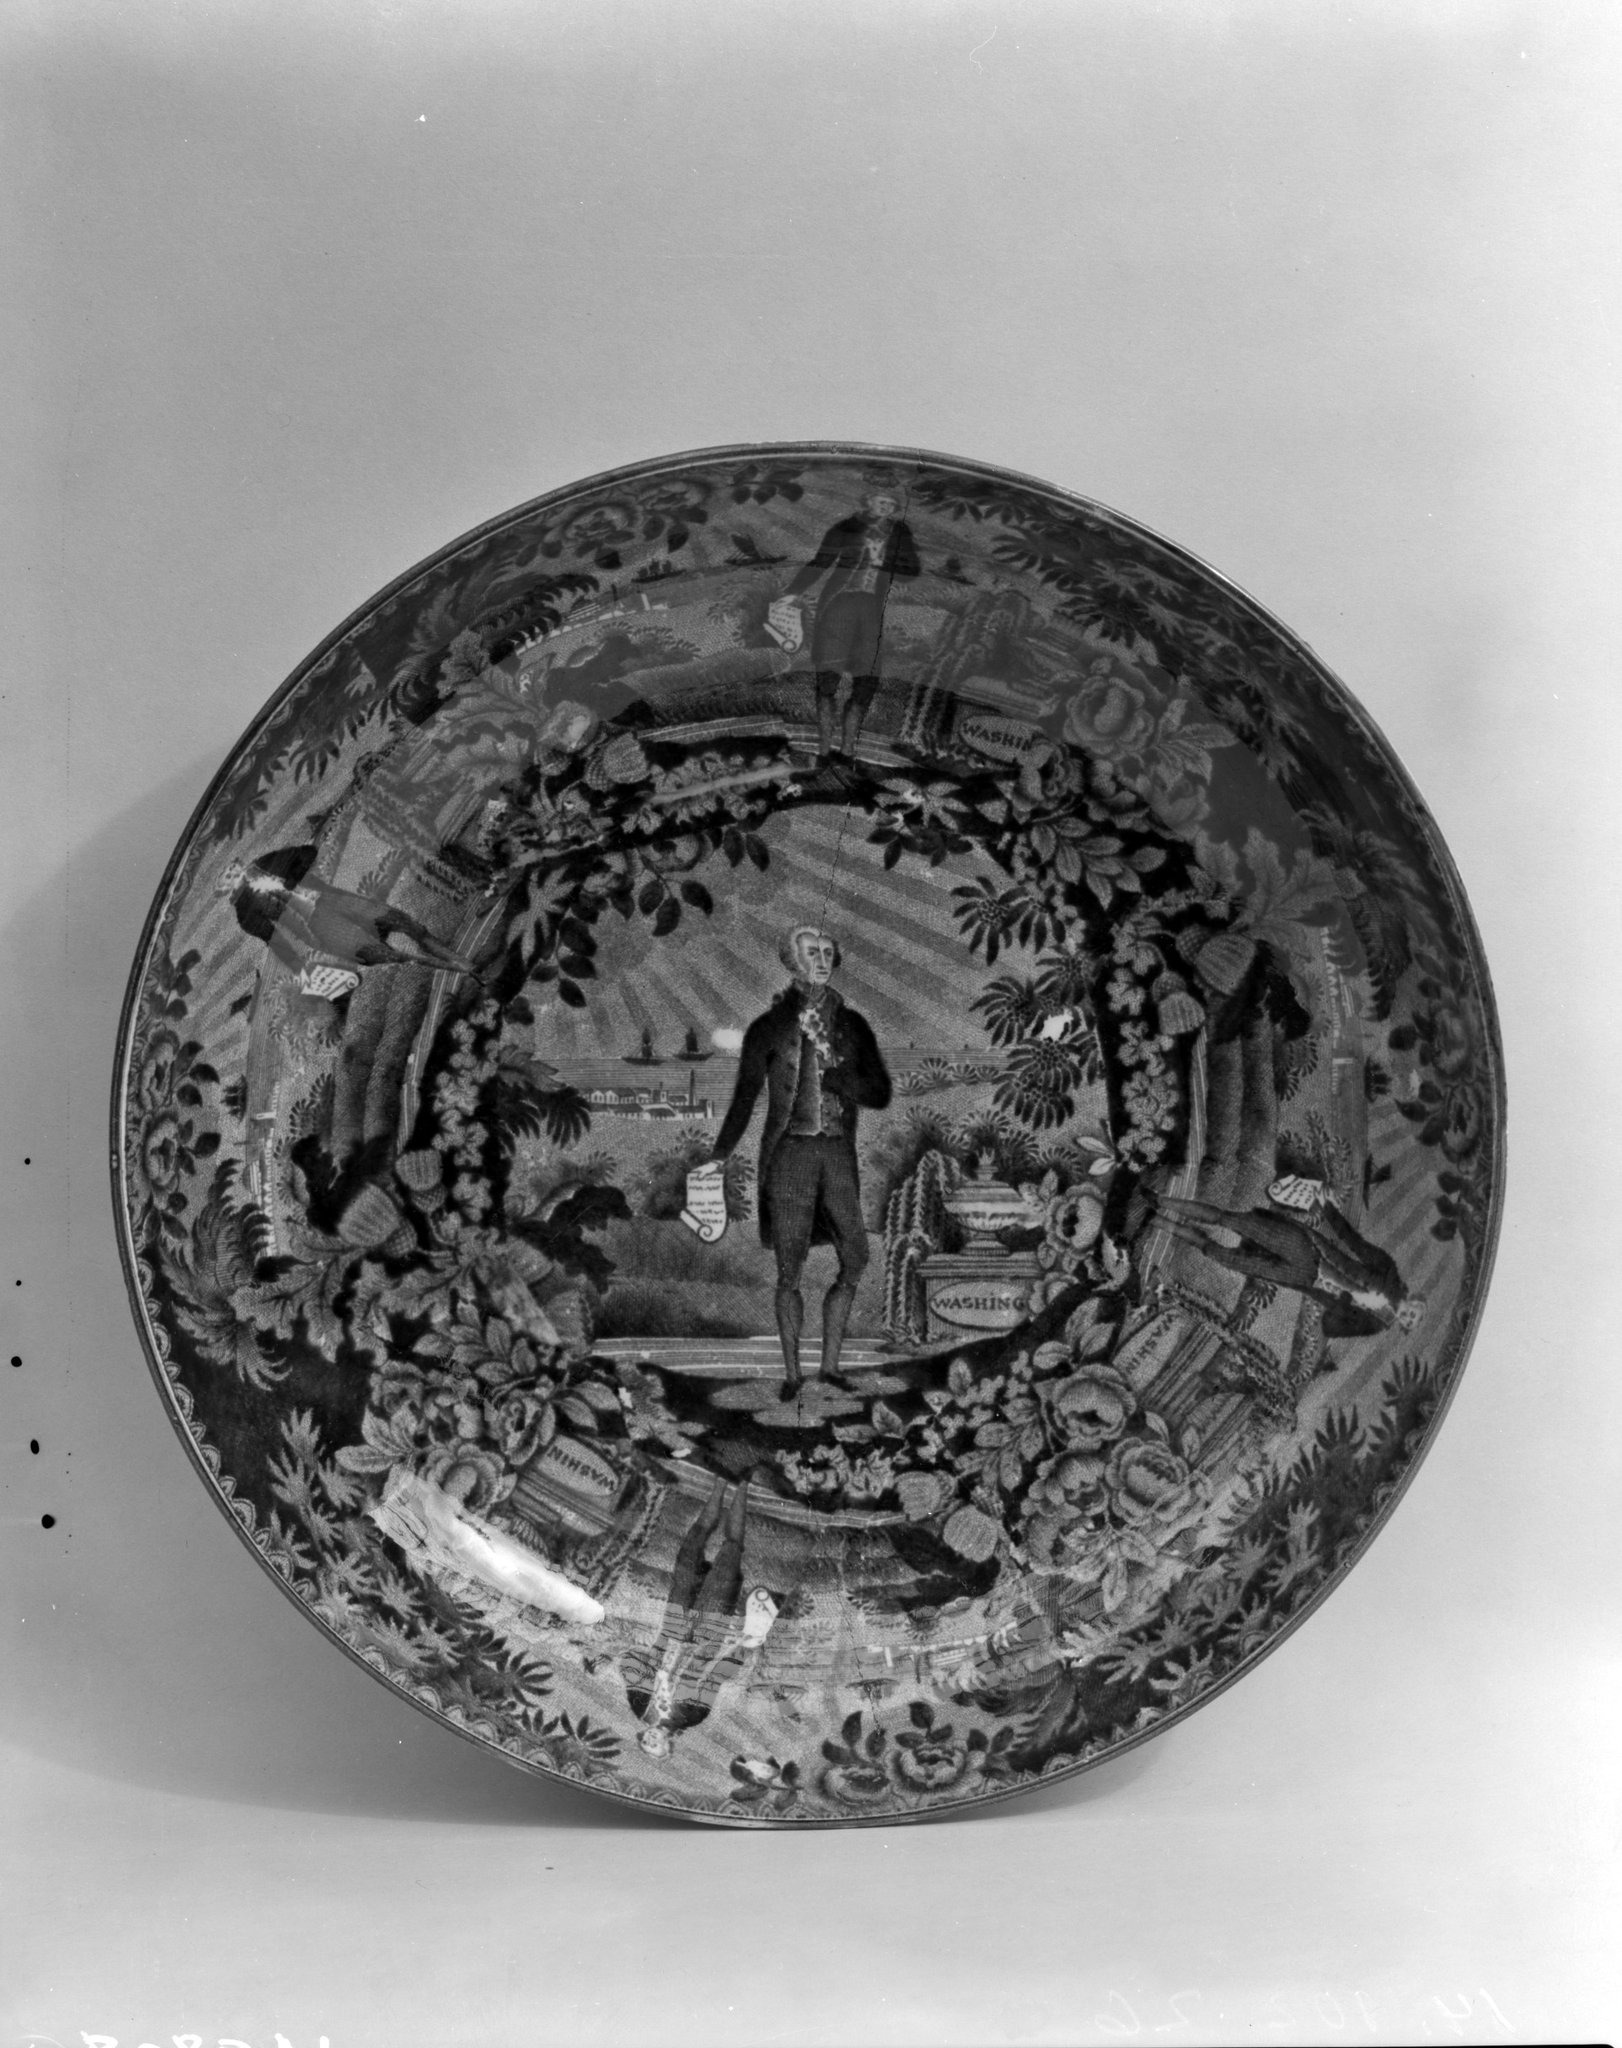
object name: dish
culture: british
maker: enoch wood & sons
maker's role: maker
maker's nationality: british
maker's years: 1818-1846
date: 1818-1846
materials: earthenware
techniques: transfer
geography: england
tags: george washington,men